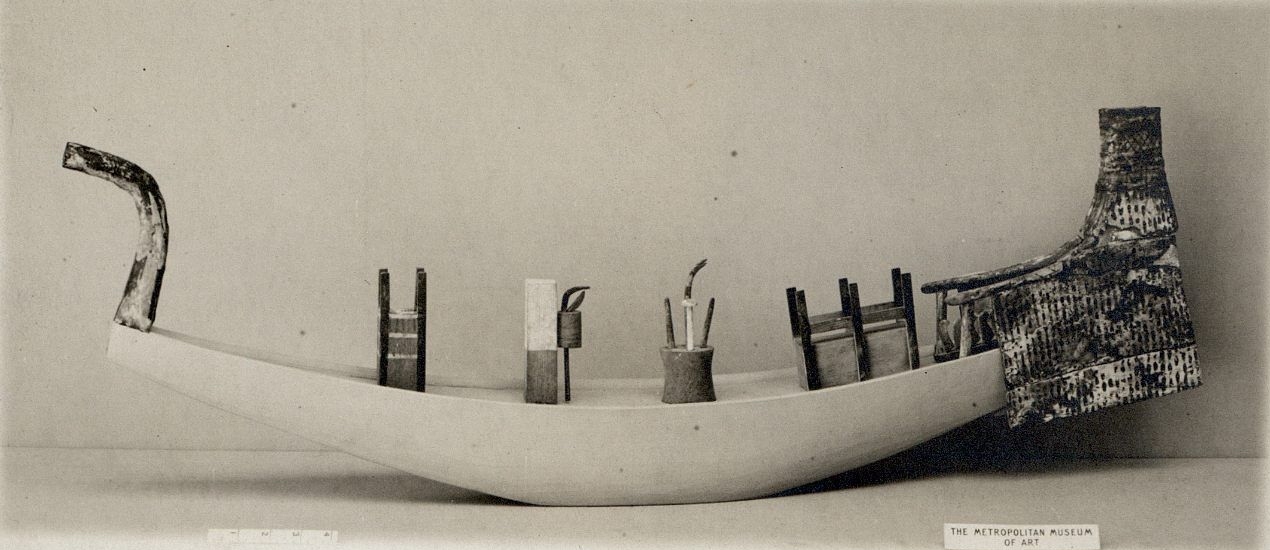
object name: model boat, imhotep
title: Model Solar Boat of Imhotep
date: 1859-1640 BCE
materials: paint, plaster, wood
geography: egypt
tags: boats